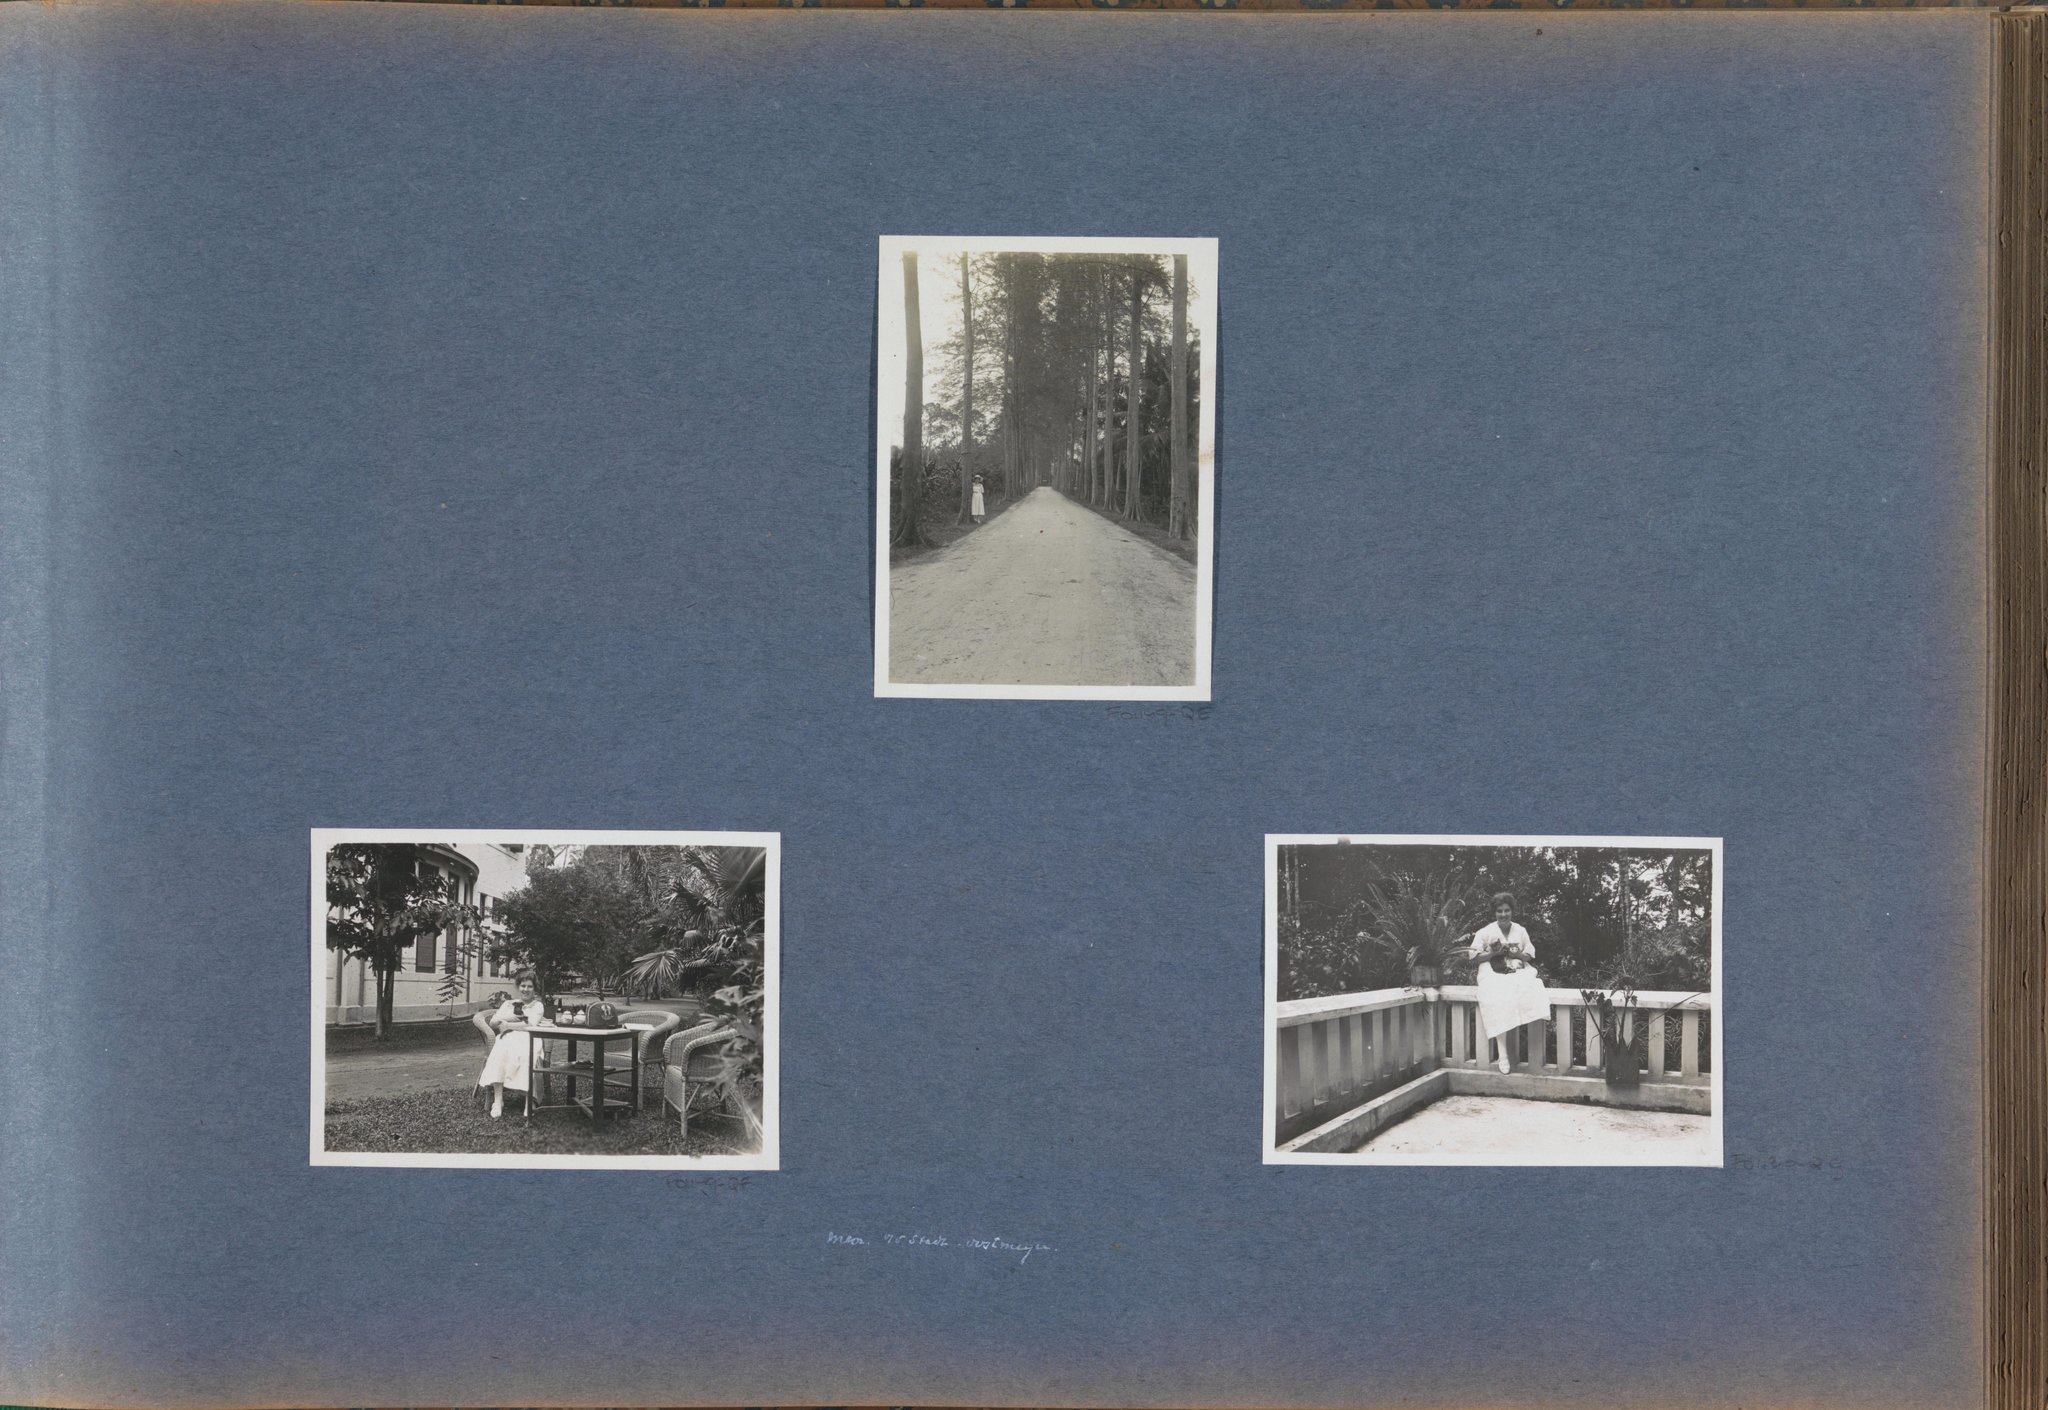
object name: album leaf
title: Vrouw aangeduid als 'mevr. v/d. Sta[(...)]-Oostmeijer' zittend op een balustrade met twee katten op schoot in Nederlands-Indië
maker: Anonymous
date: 1900-1920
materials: paper, photographic support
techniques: gelatin silver print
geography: dutch east indies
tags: adult woman, cat, loggia, verandah, porch, dutch east indies, the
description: Onderdeel van reisalbum met foto's van bedrijvigheid en bezienswaardigheden op Sumatra en Java en van de reis naar en van Nederlands-Indië.